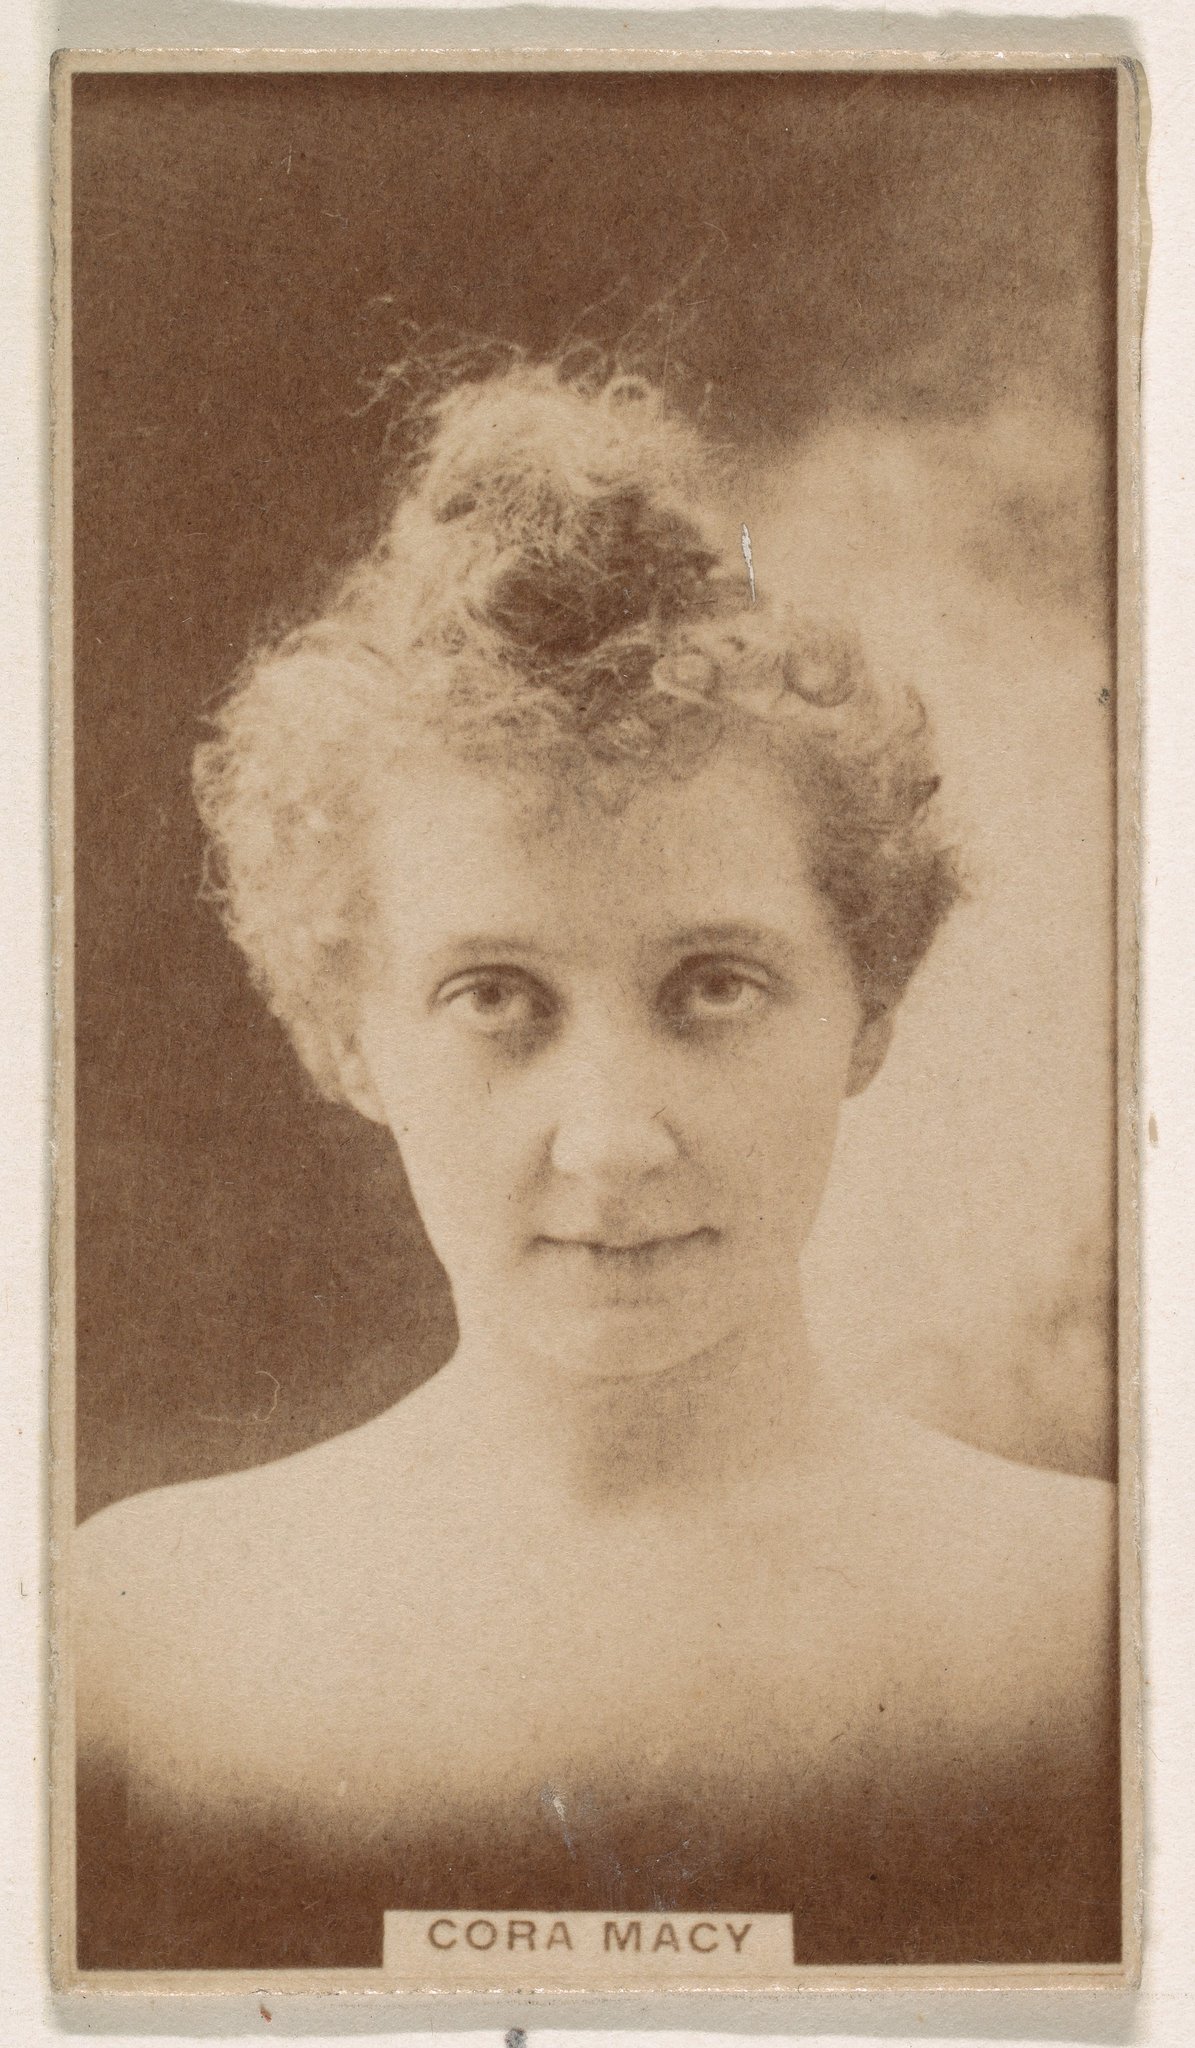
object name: photograph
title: Cora Macy, from the Actresses series (N245) issued by Kinney Brothers to promote Sweet Caporal Cigarettes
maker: kinney brothers tobacco company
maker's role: publisher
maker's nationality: american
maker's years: 1869-2011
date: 1890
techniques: albumen silver print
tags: portraits,women,actresses